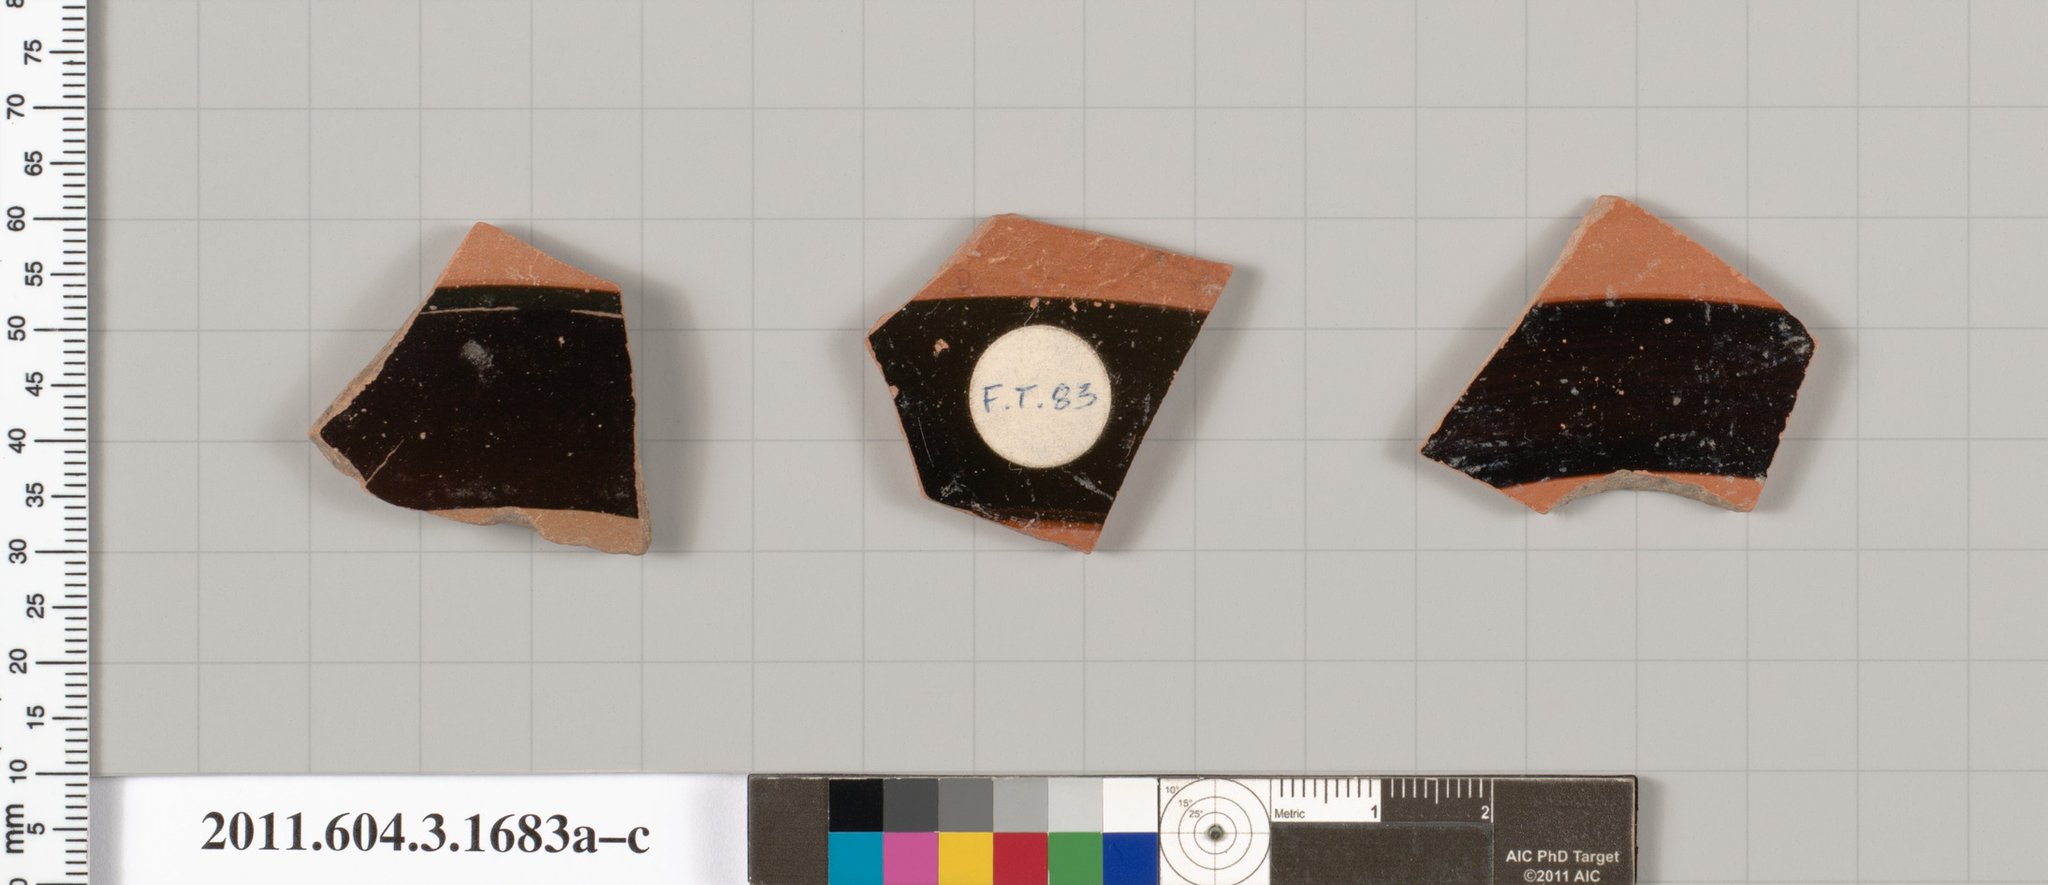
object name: kylix fragment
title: Terracotta fragments of kylikes: Band or lip cups (drinking cups)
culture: greek, attic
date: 550-526 BCE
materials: terracotta